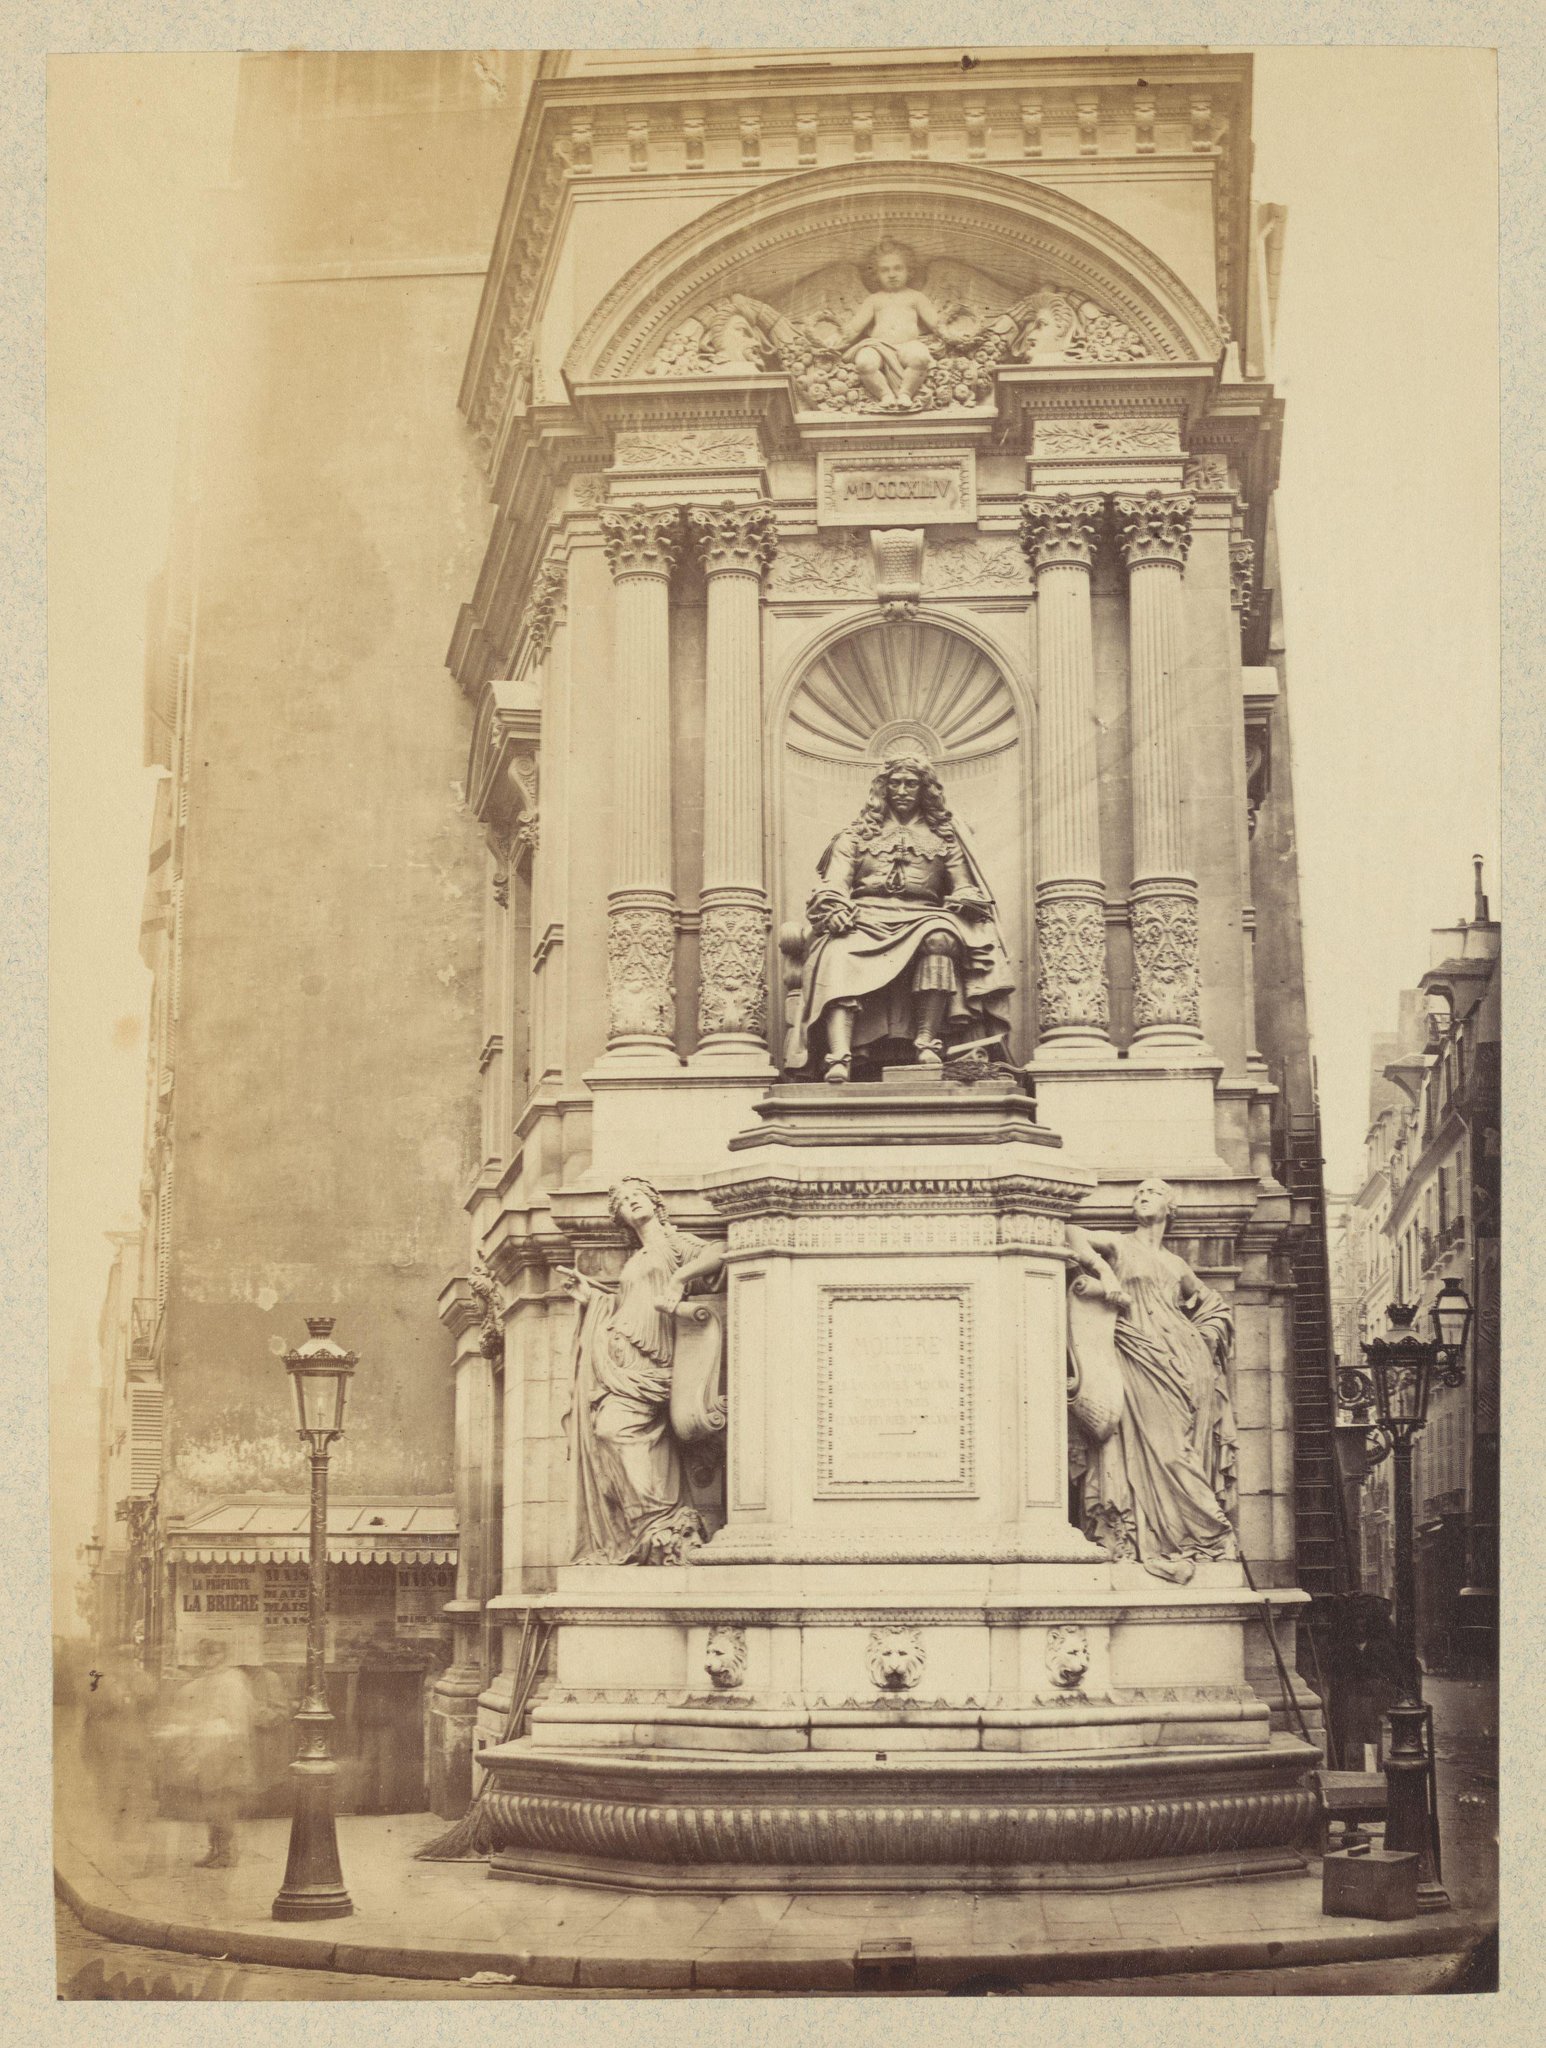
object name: photograph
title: Gezicht op Fontaine Molière te Parijs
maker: Anonymous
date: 1850-1900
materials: cardboard, photographic support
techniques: albumen print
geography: paris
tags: paris, jean baptiste poquelin molière, ornamental fountain, sculpture